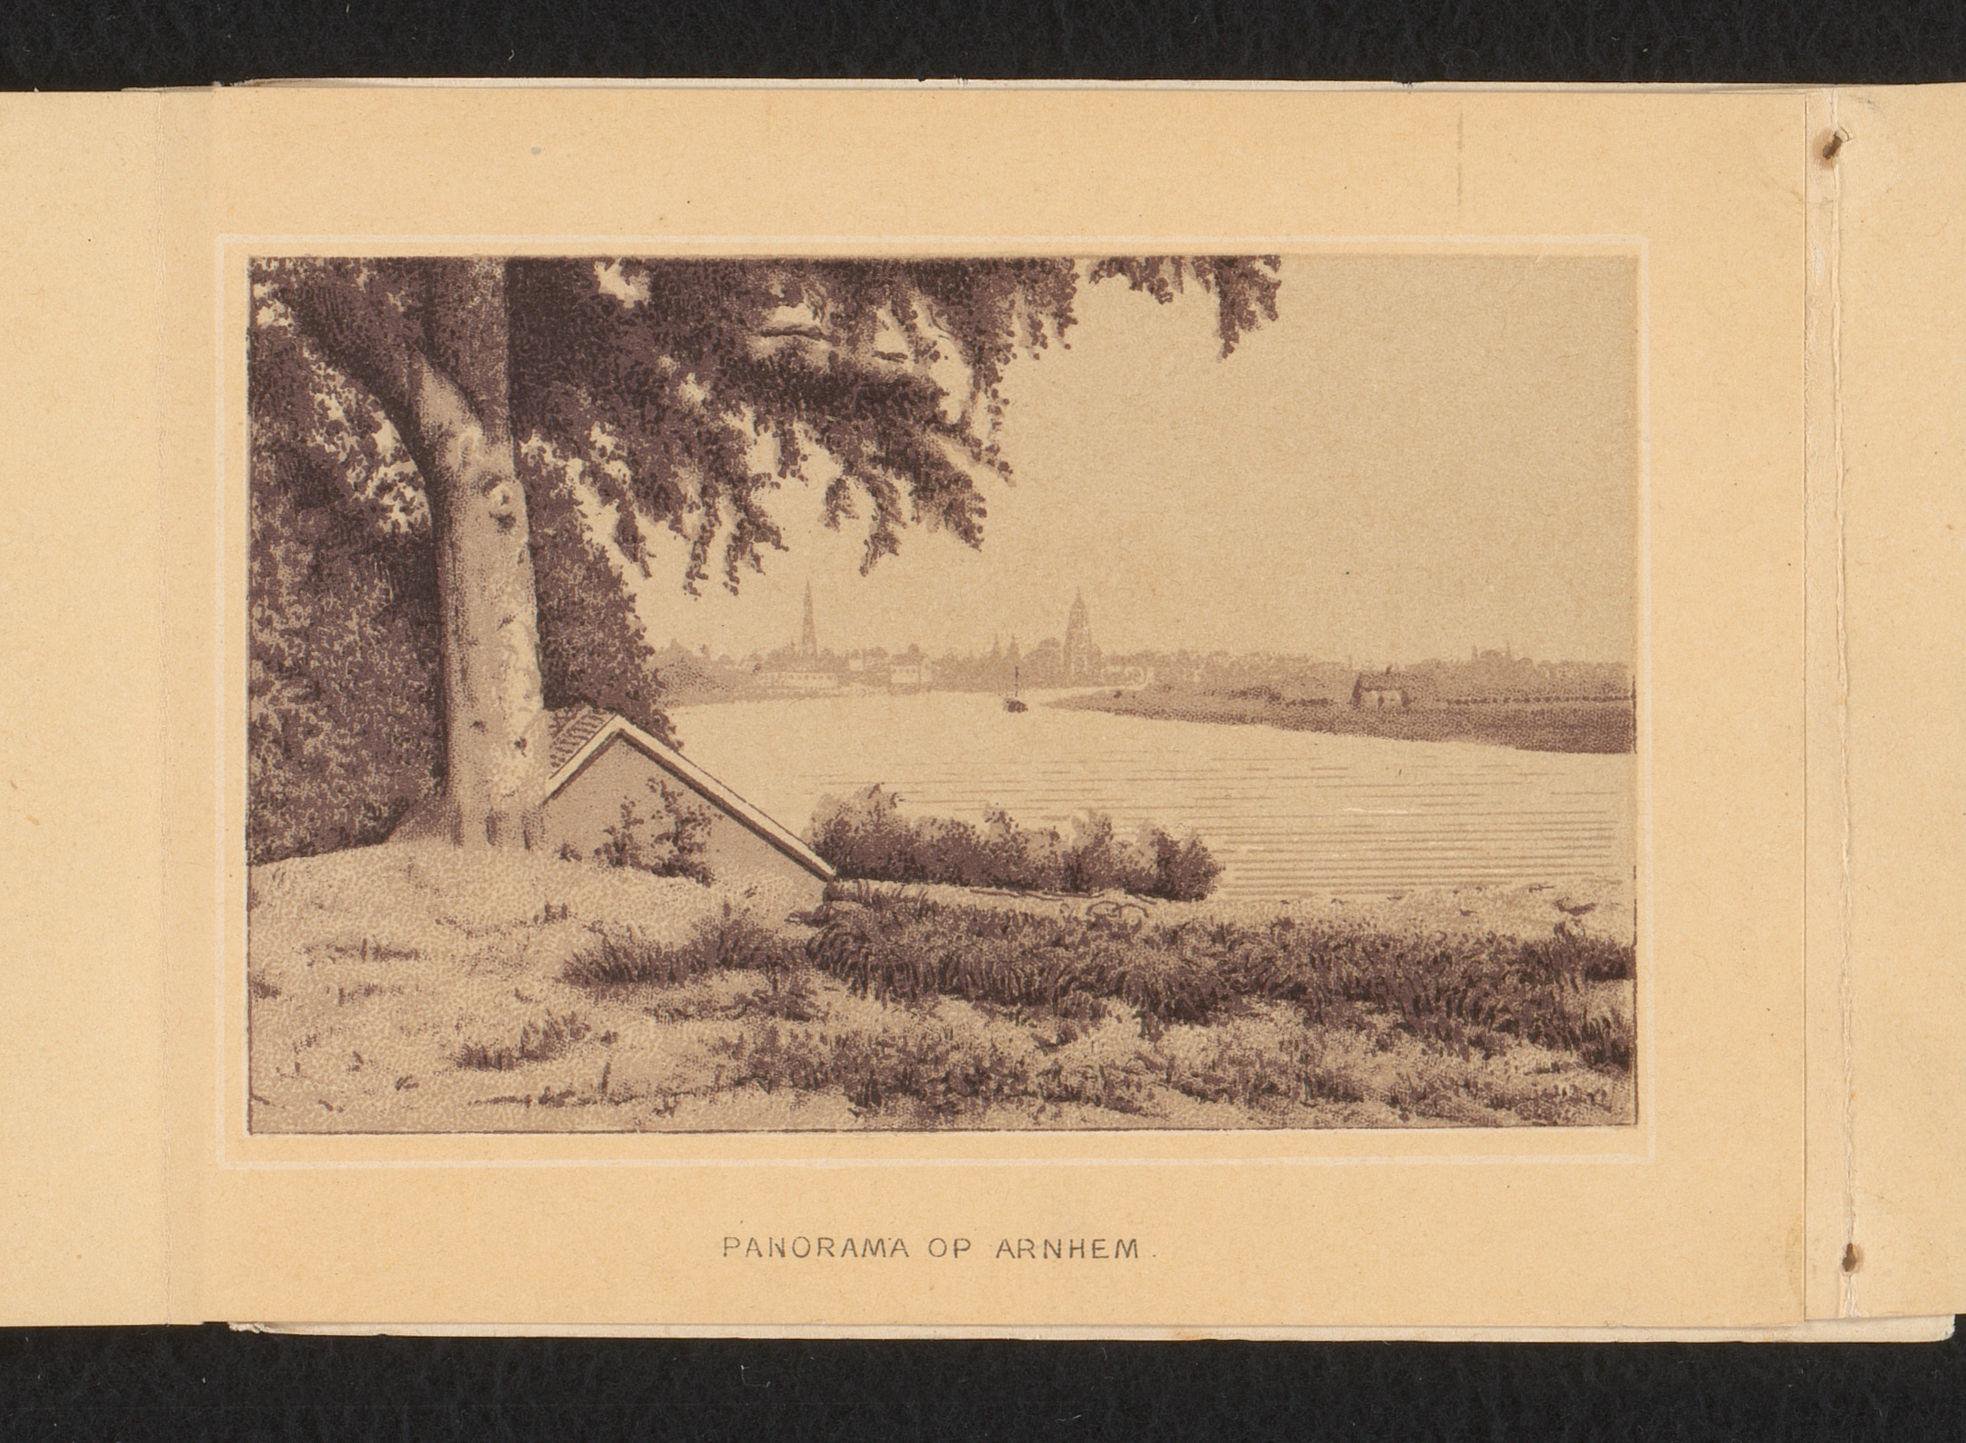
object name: print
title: Panorama op Arnhem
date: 1887-1891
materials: paper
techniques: lithograph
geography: amsterdam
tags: river, prospect of city, town panorama, silhouette of city, arnhem